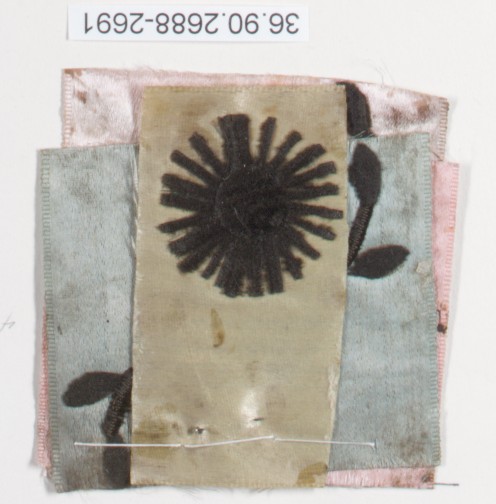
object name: ribbon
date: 1801-1900